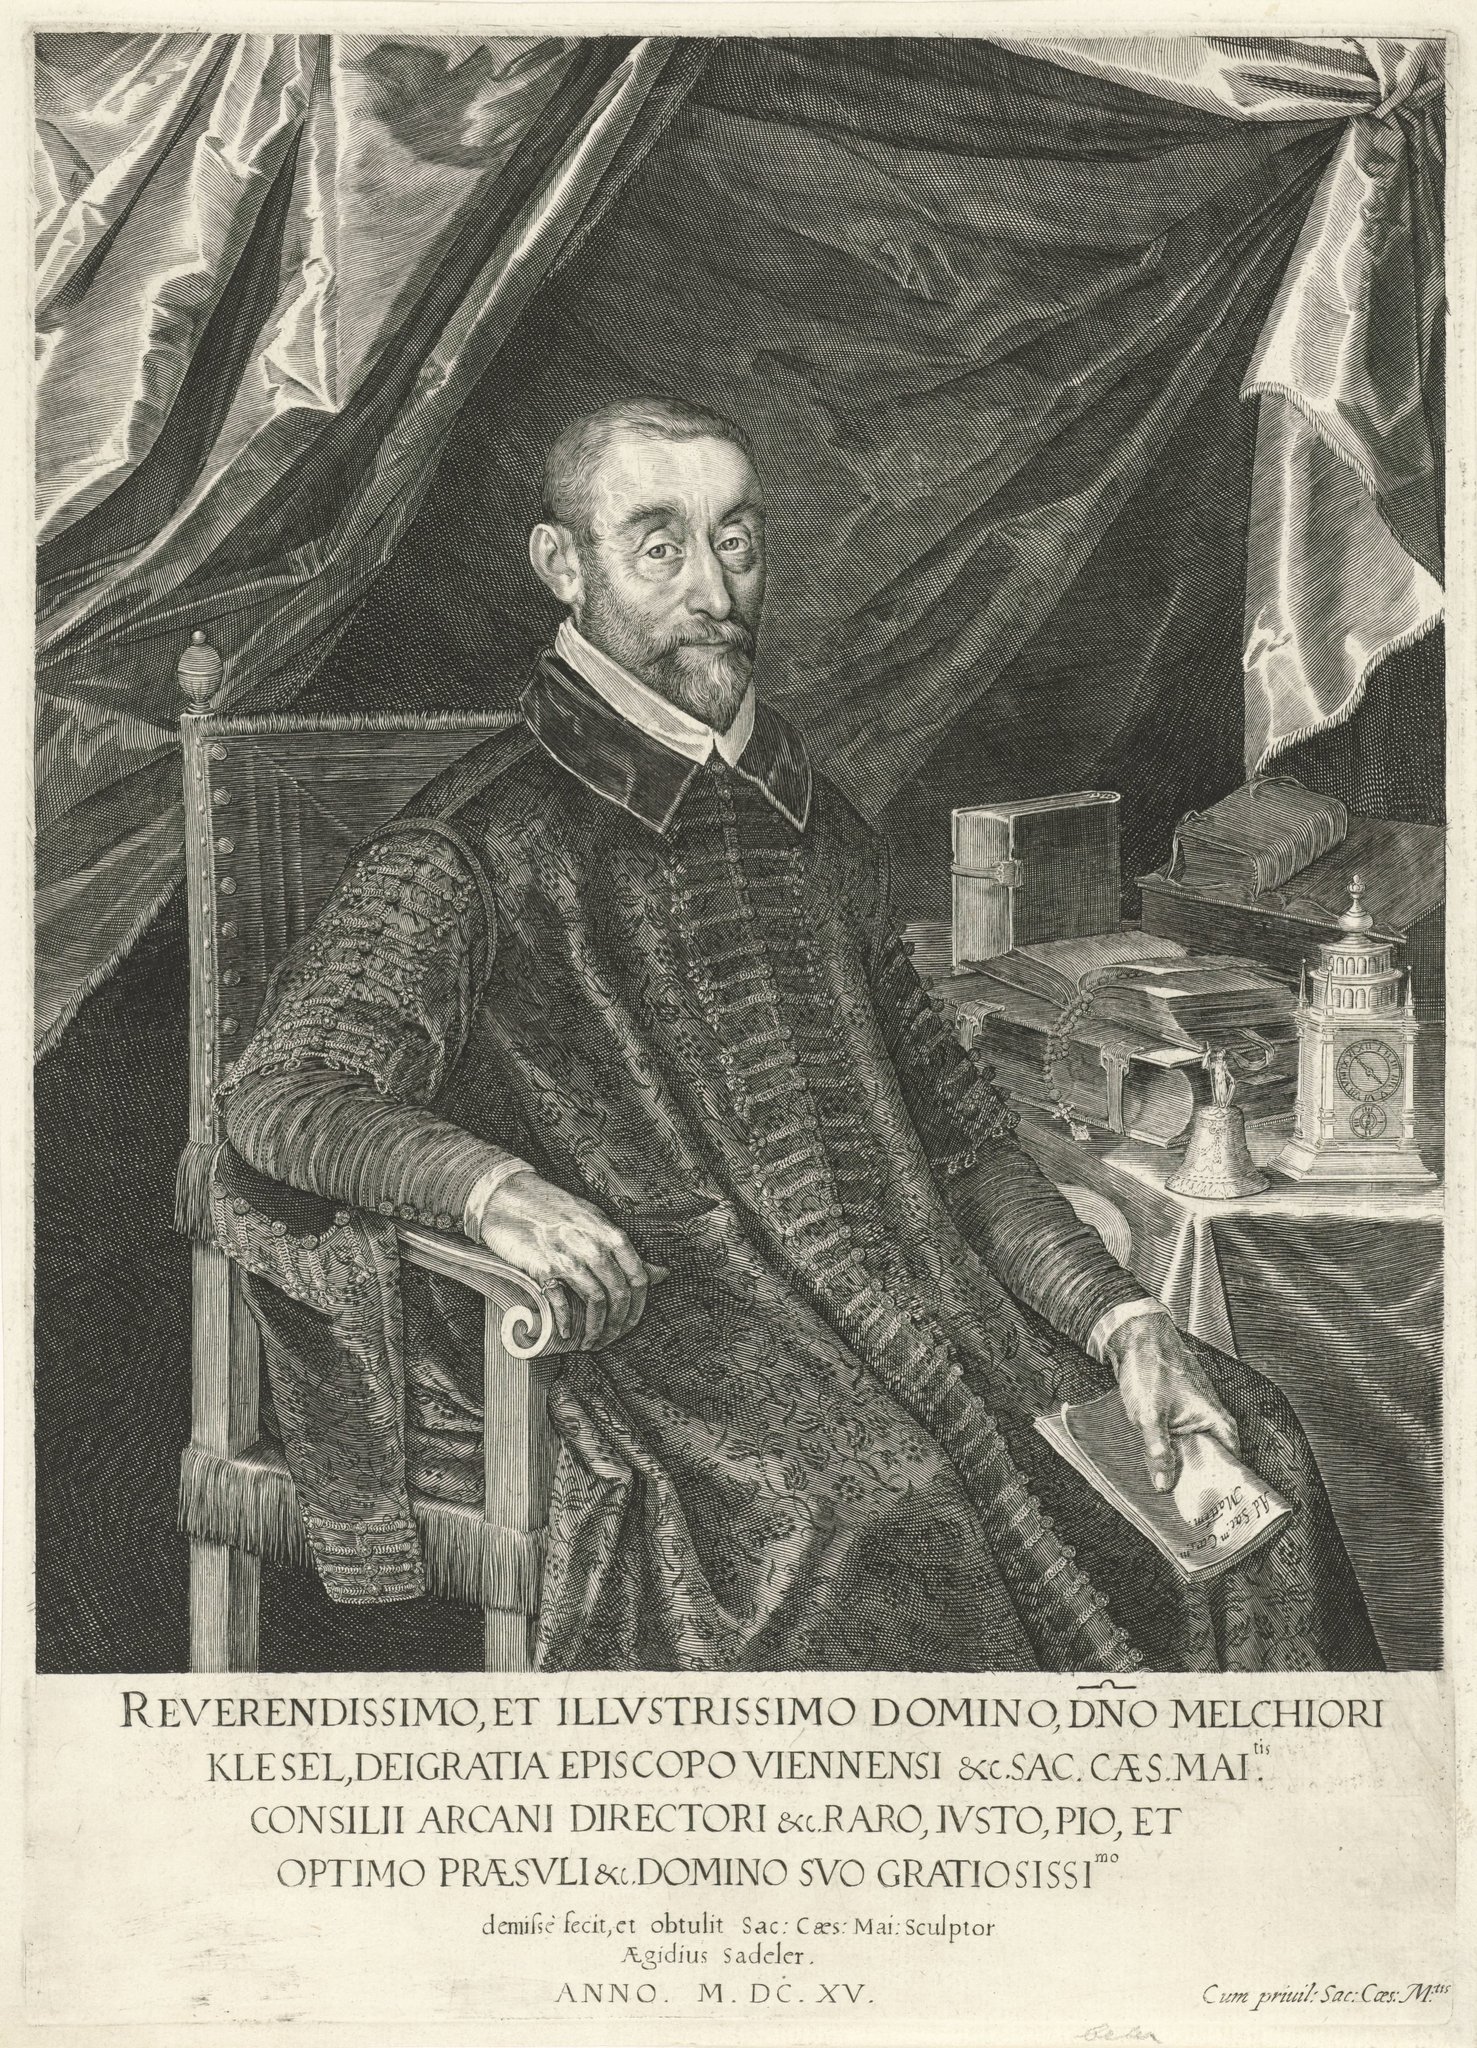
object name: print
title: Portret van Melchior Klesel, aartsbisschop van Wenen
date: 1615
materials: paper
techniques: engraving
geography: prague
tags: vienna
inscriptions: collector's mark: Lugt 2228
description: Melchior Klesel, aartsbischop van Wenen, minister van keizer Matthias en leider van de katholieke contra-reformatie. Hij zit bij een tafel met boeken en een klok. De prent heeft een Latijns onderschrift.